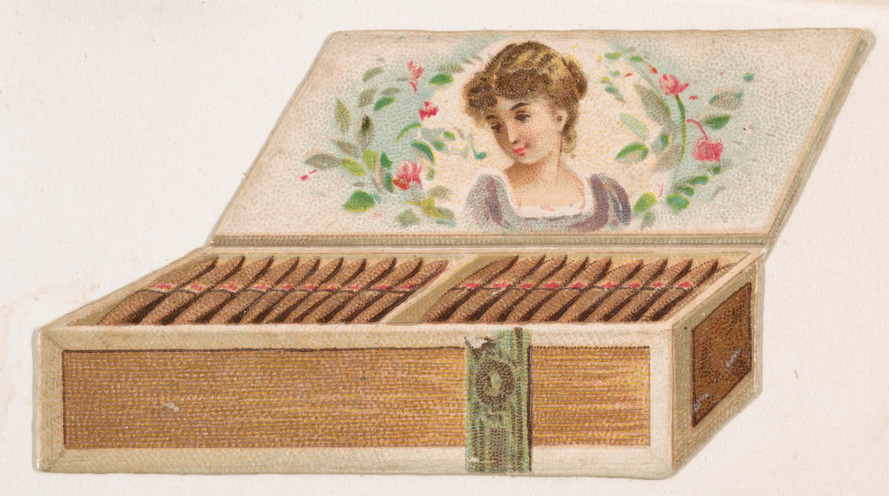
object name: print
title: Cigar box, from the Novelties series (N228, Type 4) issued by Kinney Bros.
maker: kinney brothers tobacco company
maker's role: publisher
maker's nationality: american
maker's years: 1869-2011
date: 1889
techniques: color lithograph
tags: women